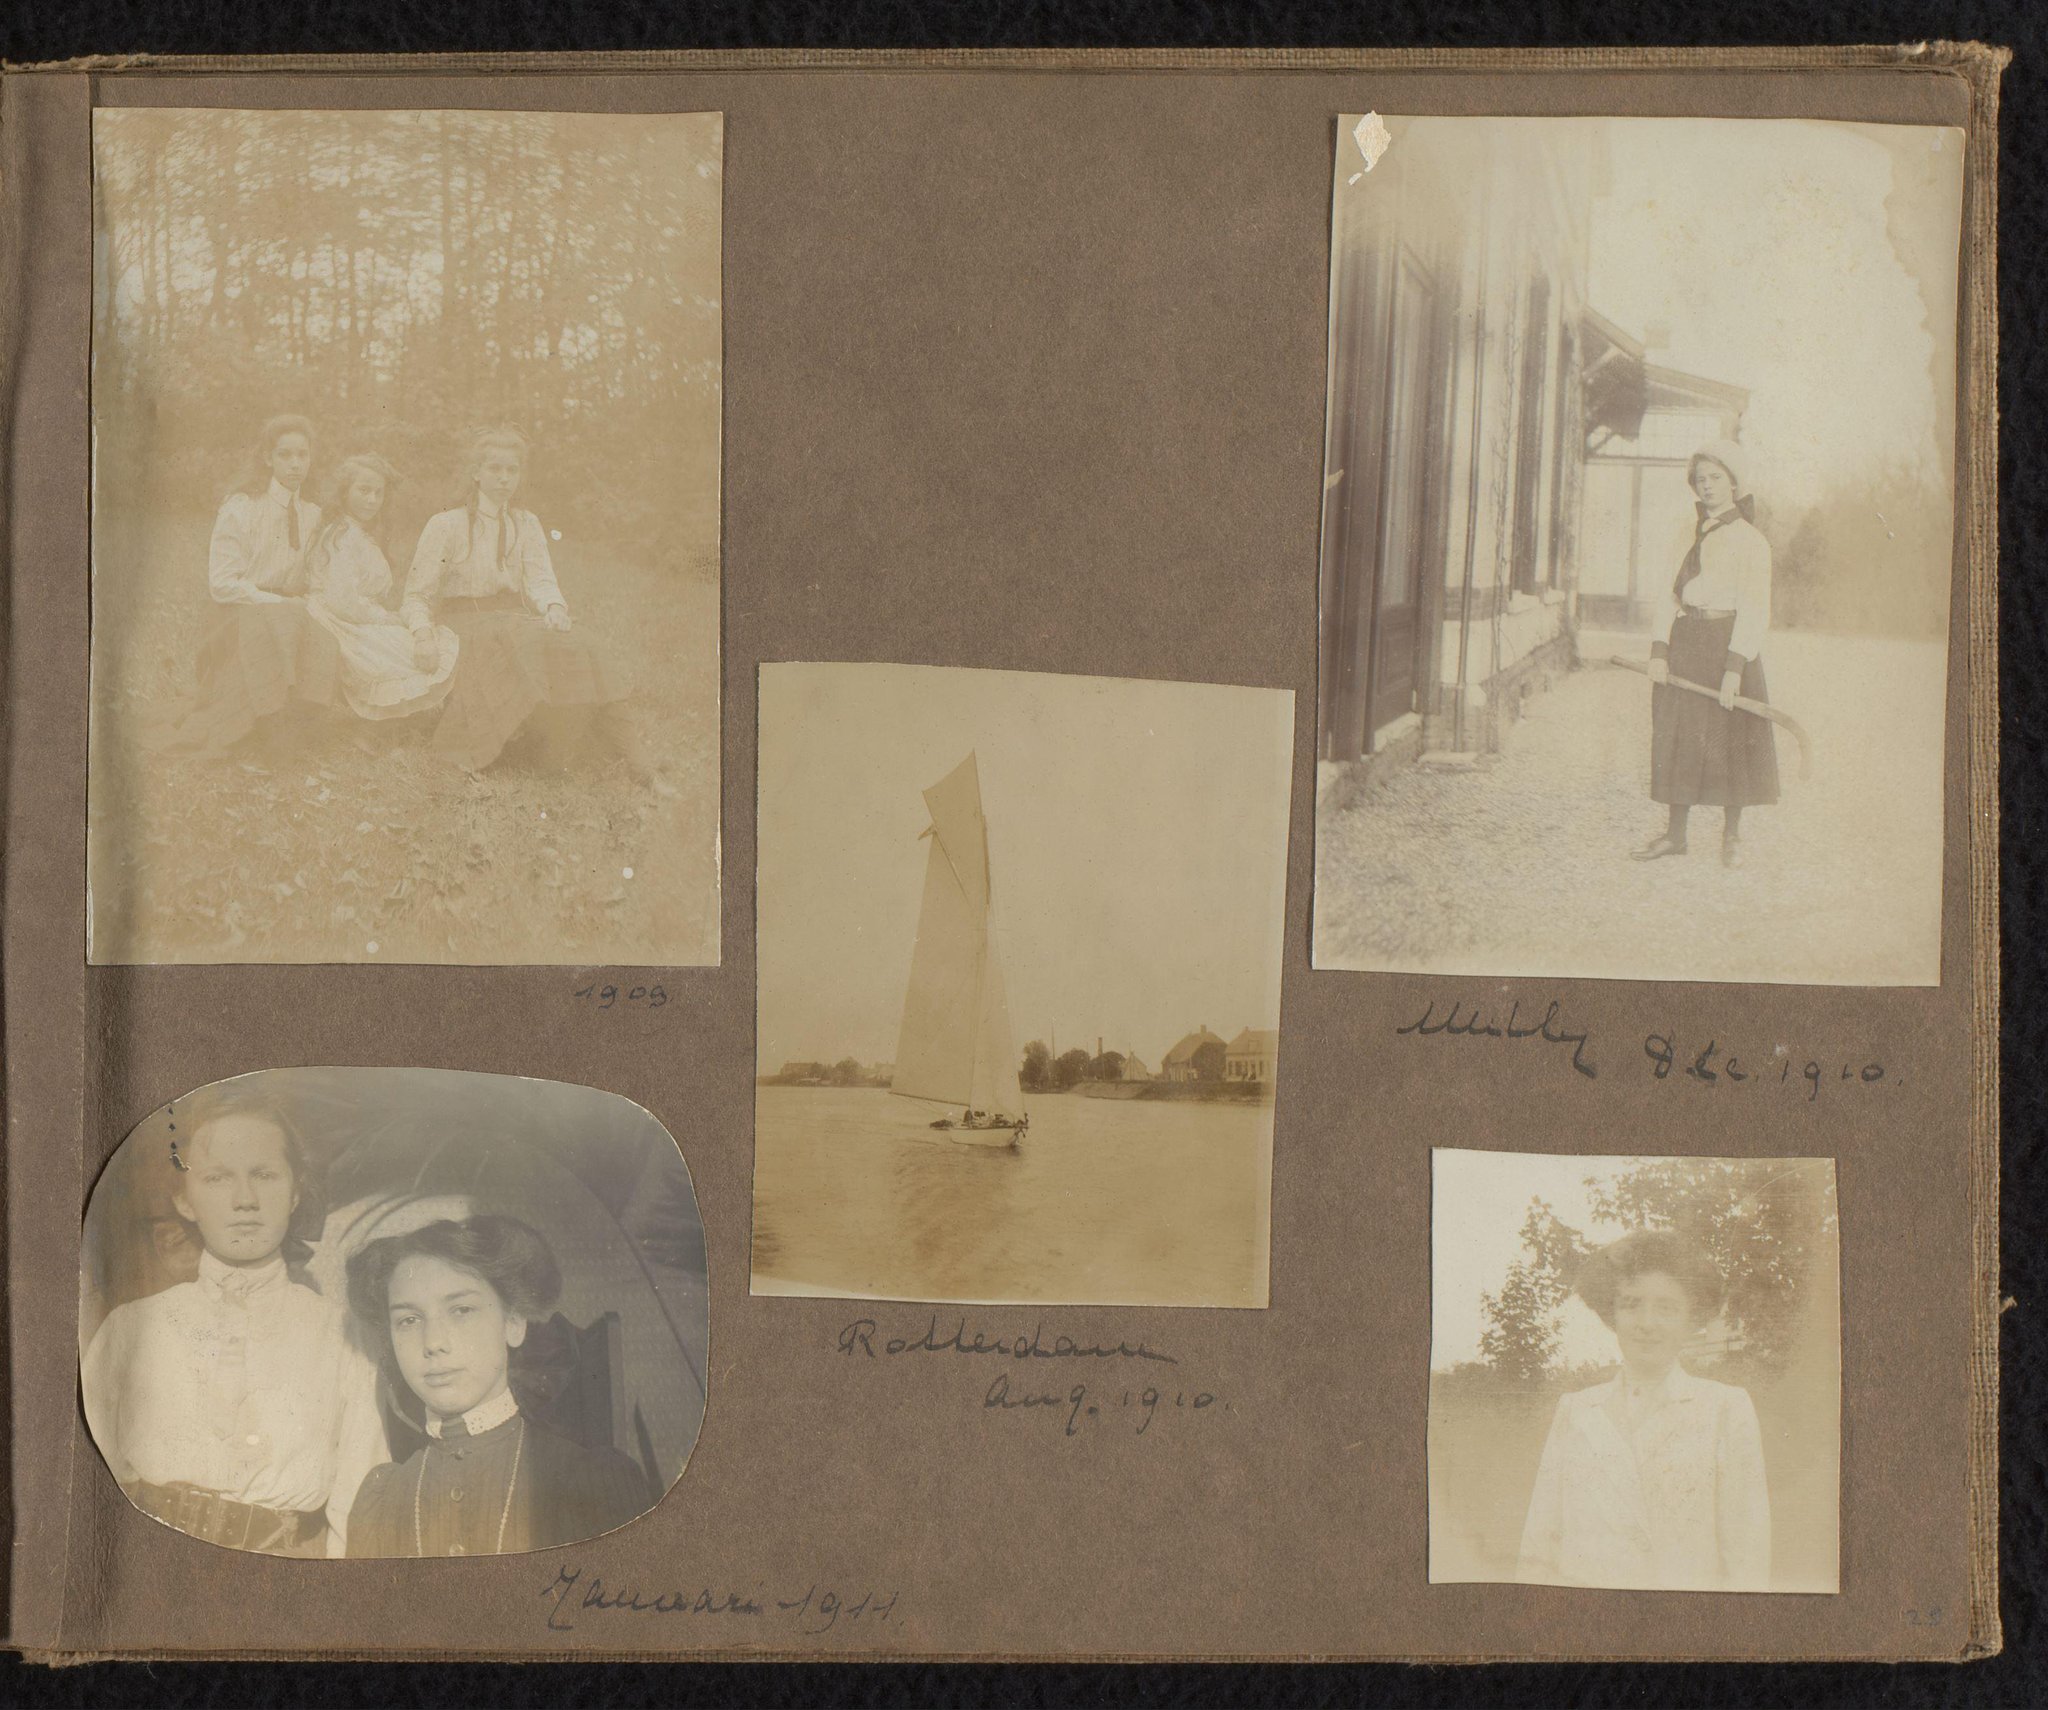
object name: photograph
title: Vijf foto's van Loentje en Willy Onnen met onder andere Winny Uhlenbeck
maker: carolina frederika onnen (lien/loen)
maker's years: 1896-1983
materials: paper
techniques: gelatin silver print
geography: netherlands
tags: amsterdam, carolina frederika onnen (lien/loen), sailing-ship, sailing-boat, historical persons - bb - woman, friends, netherlands, rotterdam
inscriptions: inscription: ‘Januari 1911’, inscription: ‘Willy Déc. 1910’, inscription: ‘Rotterdam/ Aug. 1910’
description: Deze foto's maken deel uit van een album.